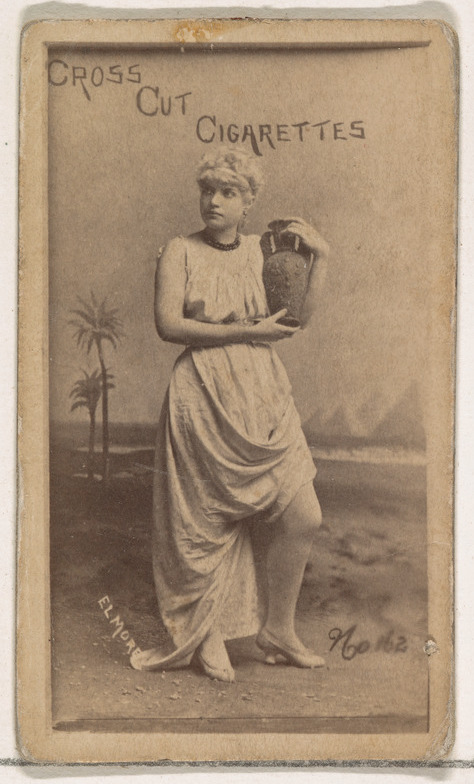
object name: print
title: Card Number 162, Elmore, from the Actors and Actresses series (N145-1) issued by Duke Sons & Co. to promote Cross Cut Cigarettes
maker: w. duke, sons & co.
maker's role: publisher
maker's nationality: american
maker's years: 1870-1920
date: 1880-1889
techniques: albumen silver print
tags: portraits,women,actresses